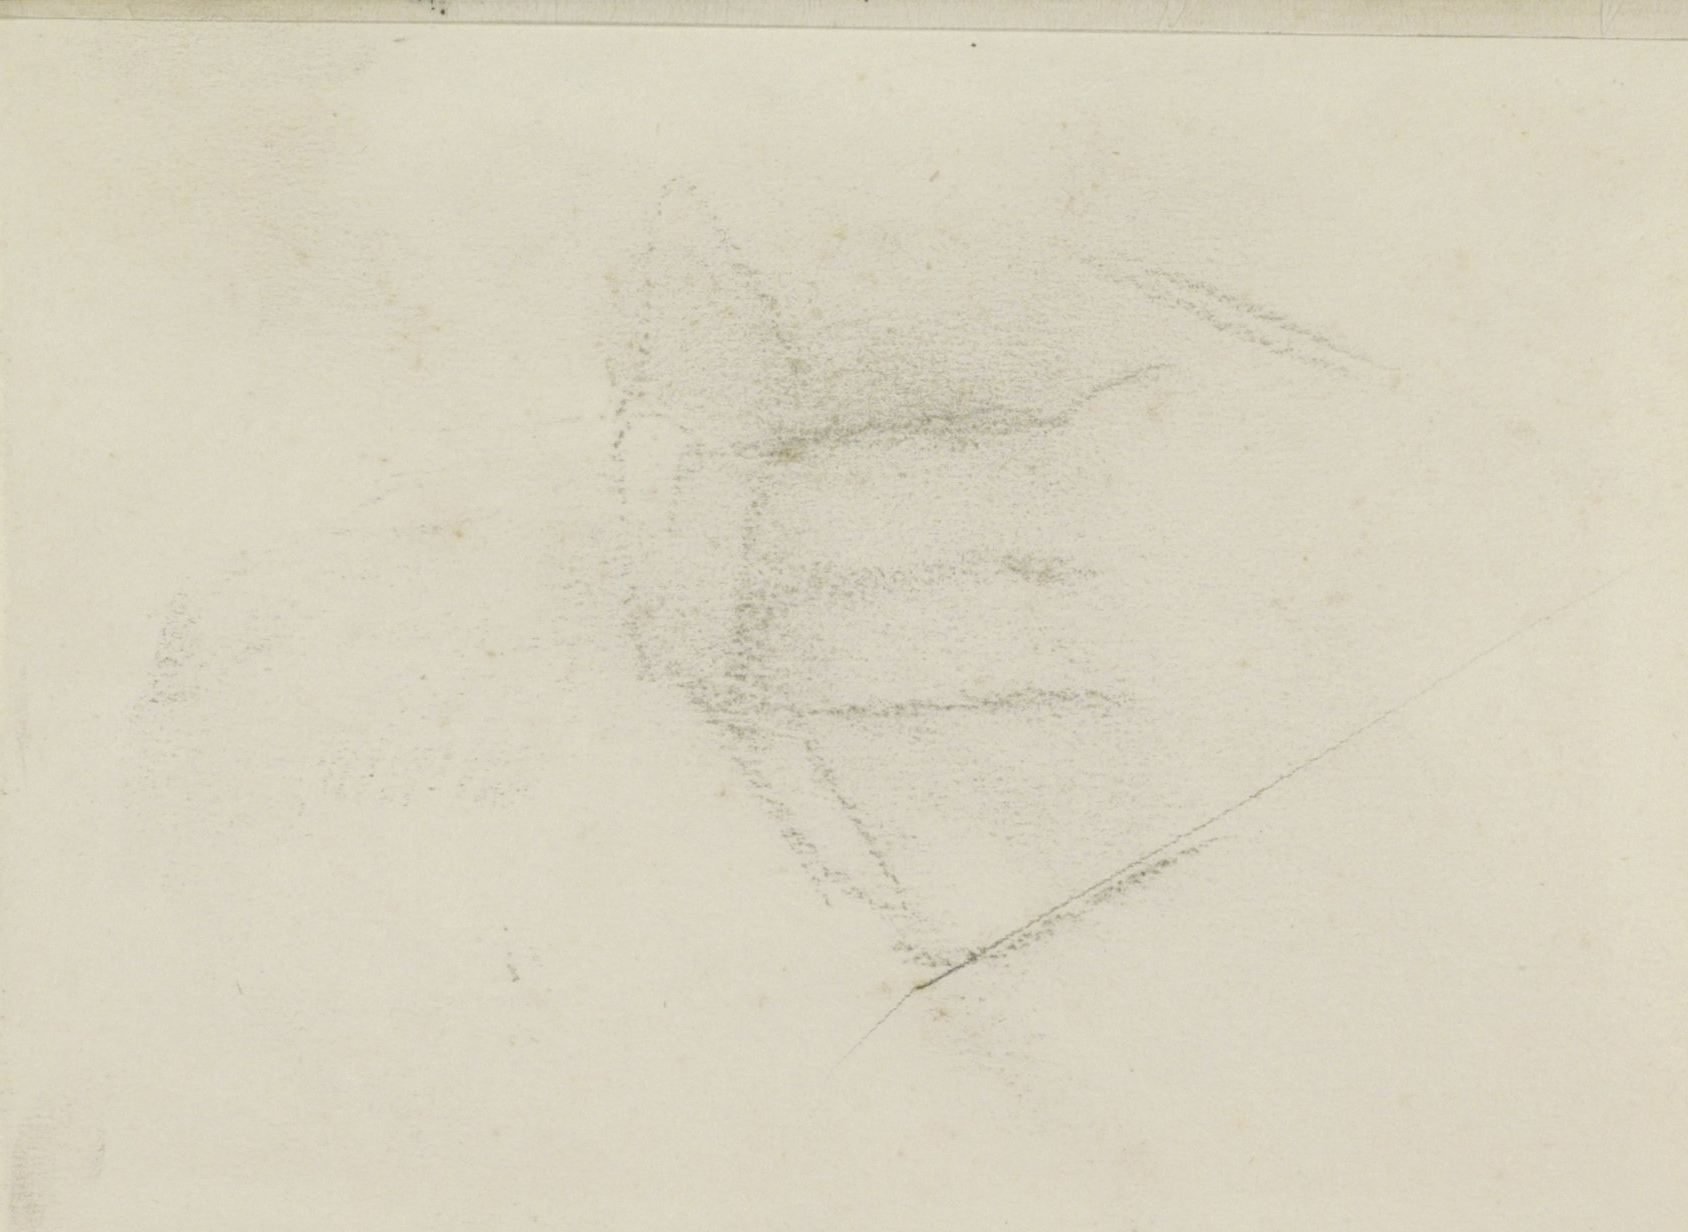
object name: sketchbook leaf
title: Studie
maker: a.a.l. de grammont-hubrecht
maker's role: draughtsman, painter, print maker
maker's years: 1855-1913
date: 1865-1913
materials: chalk, paper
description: Blad 38 recto uit een schetsboek met 38 bladen.